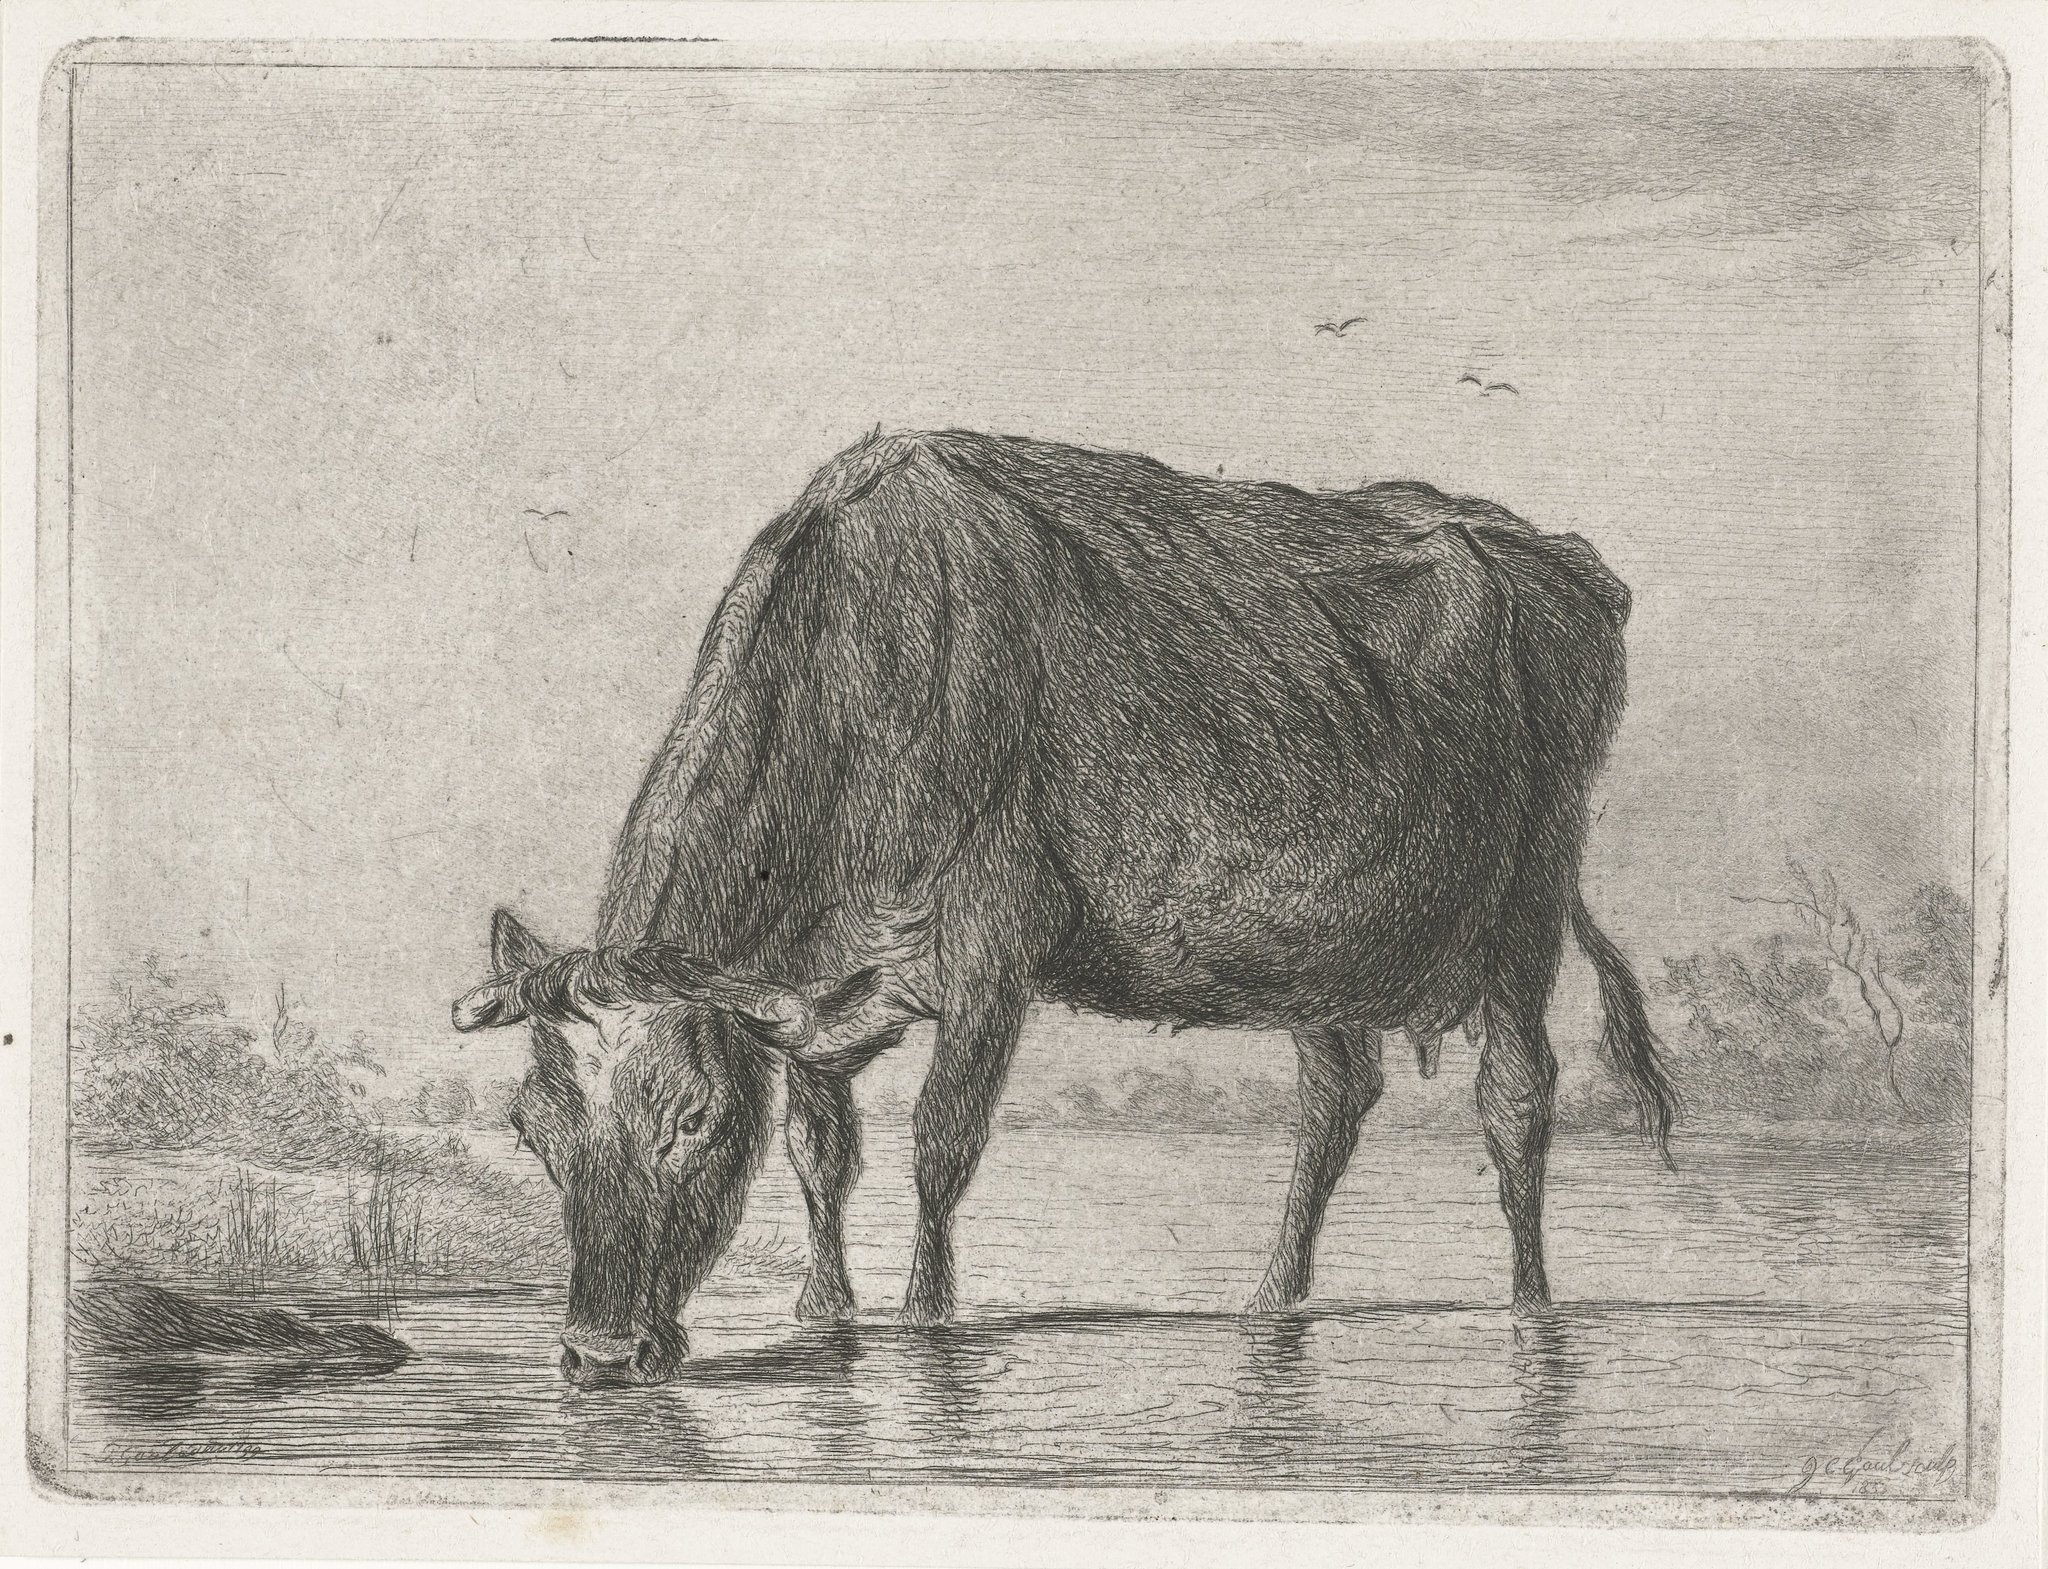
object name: print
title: Drinkende koe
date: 1851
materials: paper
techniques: etching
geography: netherlands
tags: cow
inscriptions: collector's mark: Lugt 2228